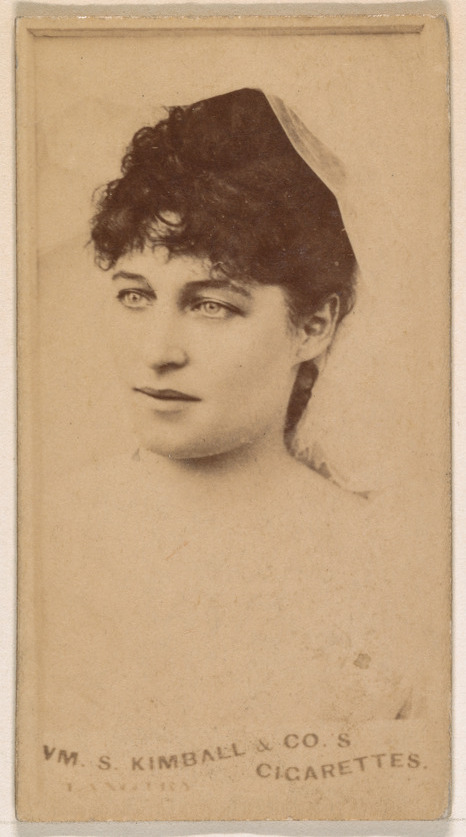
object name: photograph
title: Miss Langtry, from the Actresses series (N203) issued by Wm. S. Kimball & Co.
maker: william s. kimball & company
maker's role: publisher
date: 1889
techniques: color lithograph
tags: portraits,women,actresses